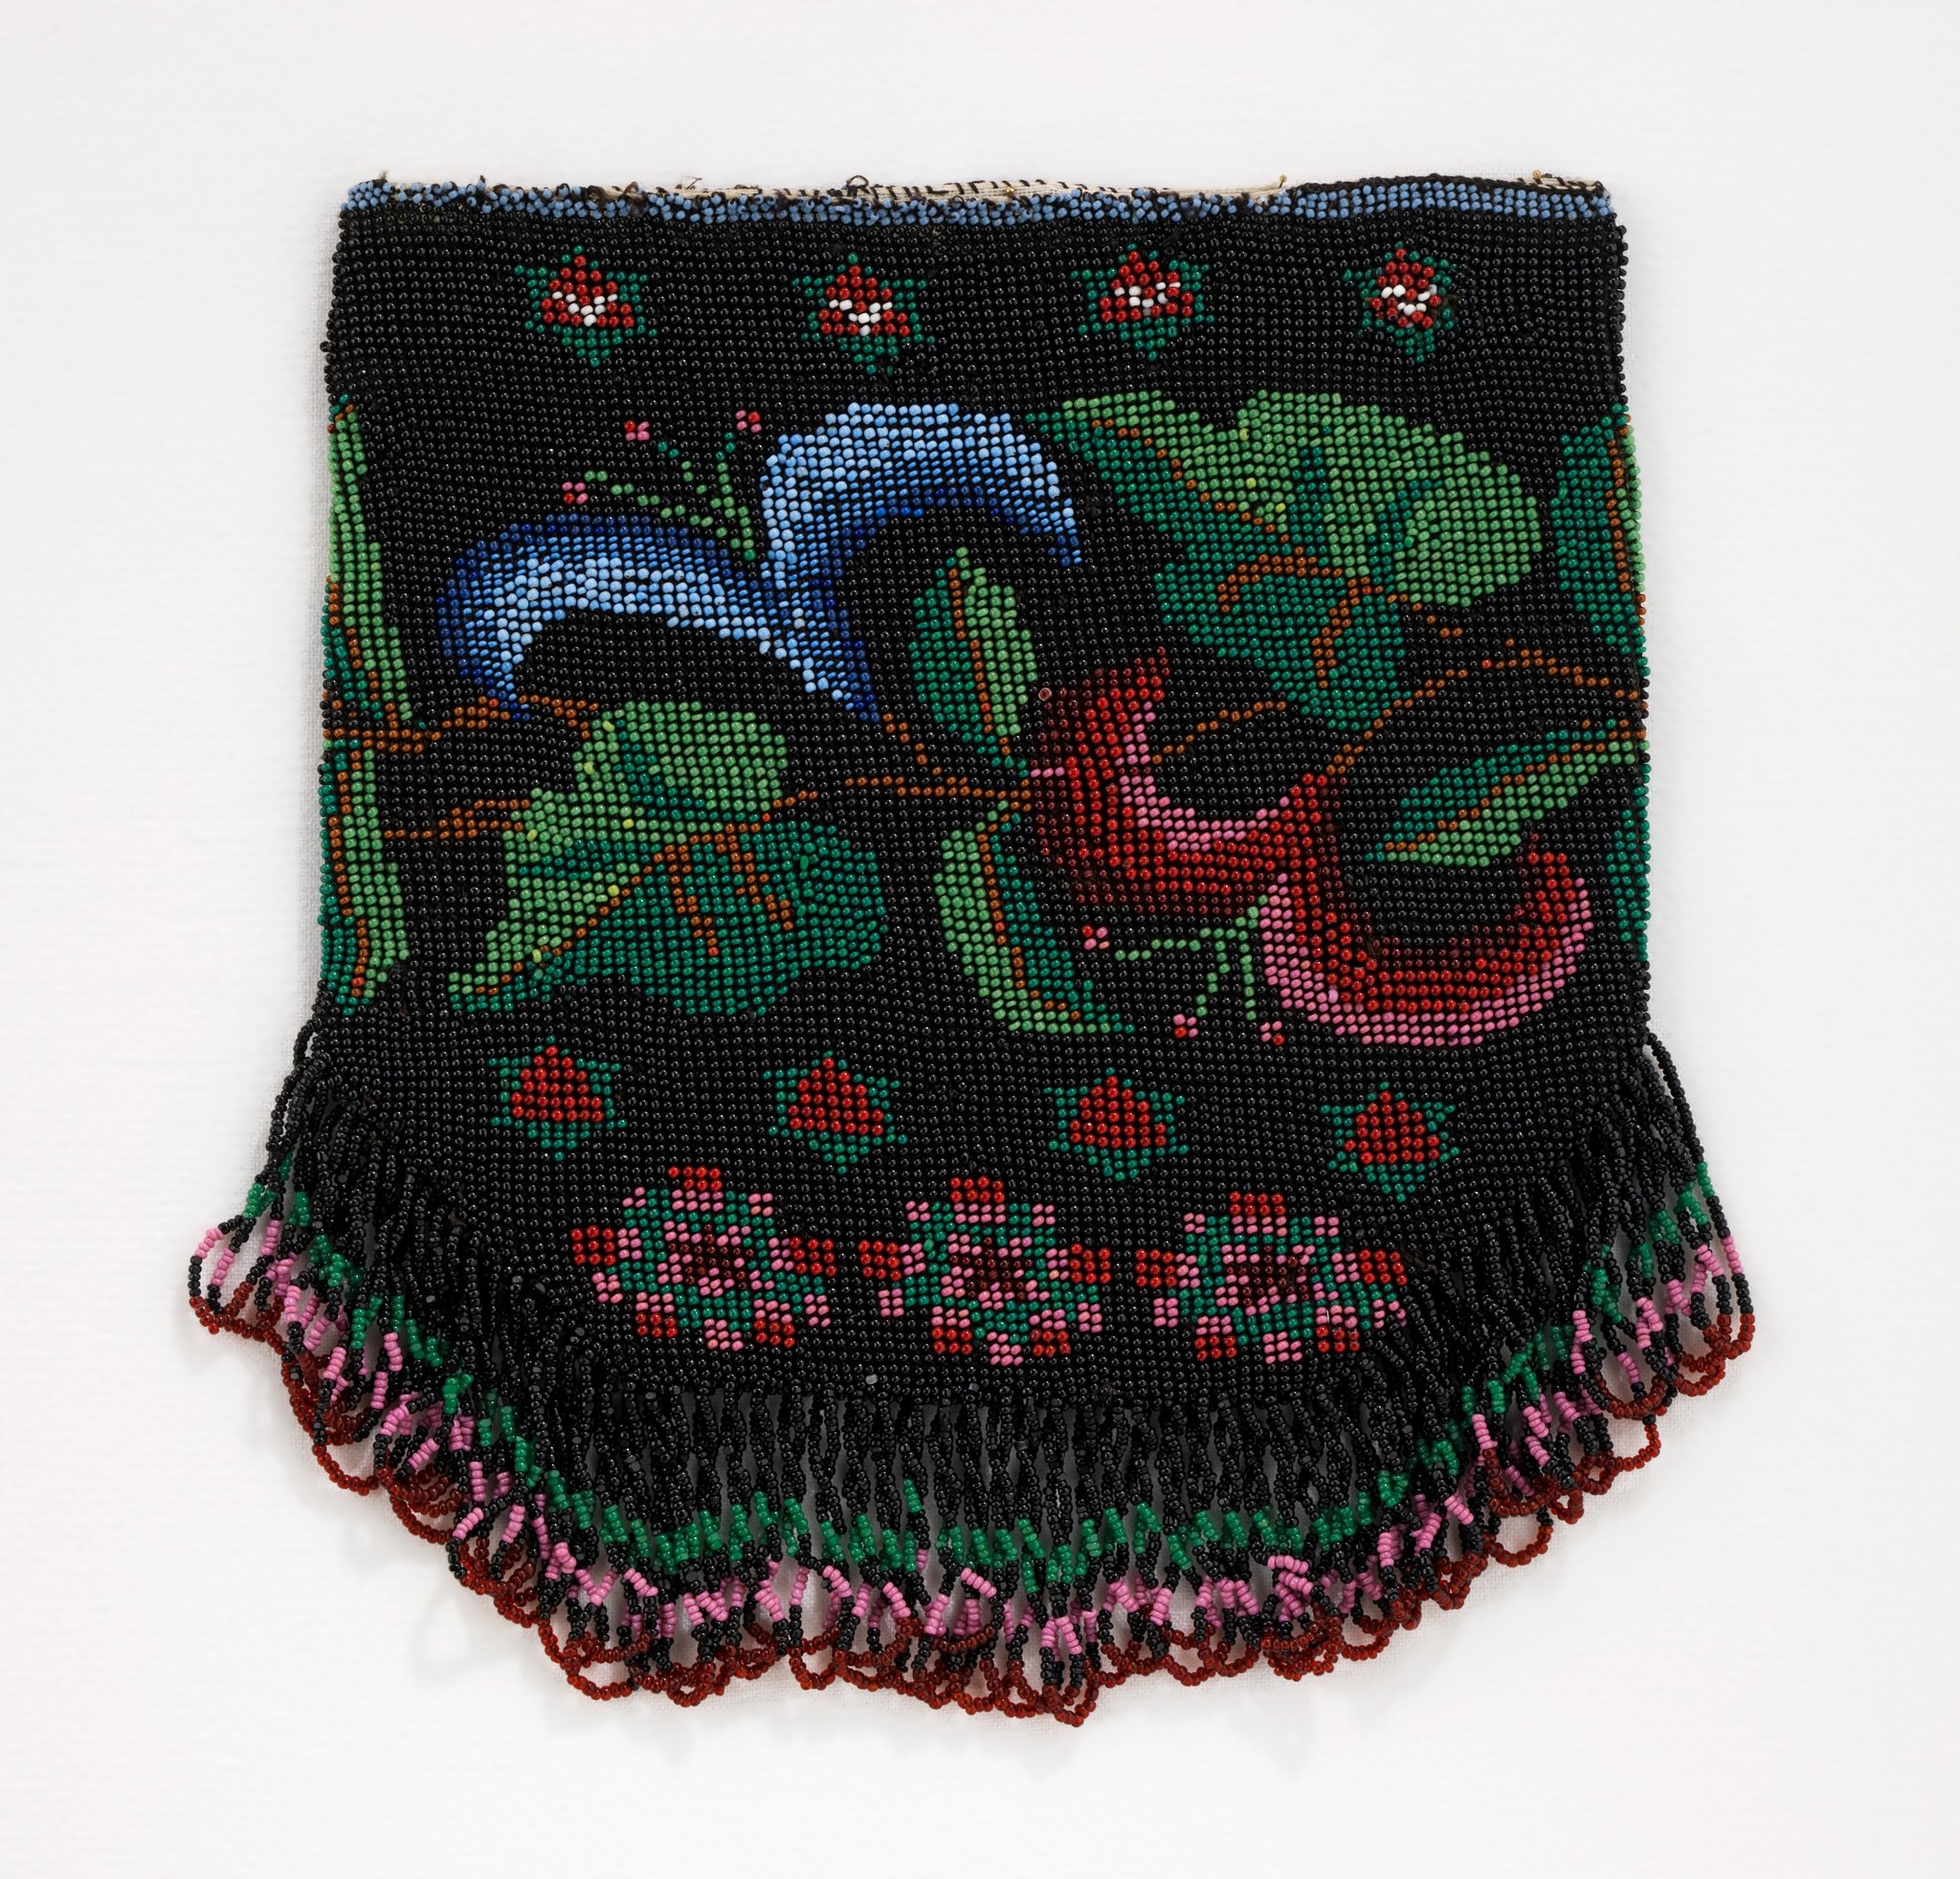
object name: pouch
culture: american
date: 1876-1900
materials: glass, linen